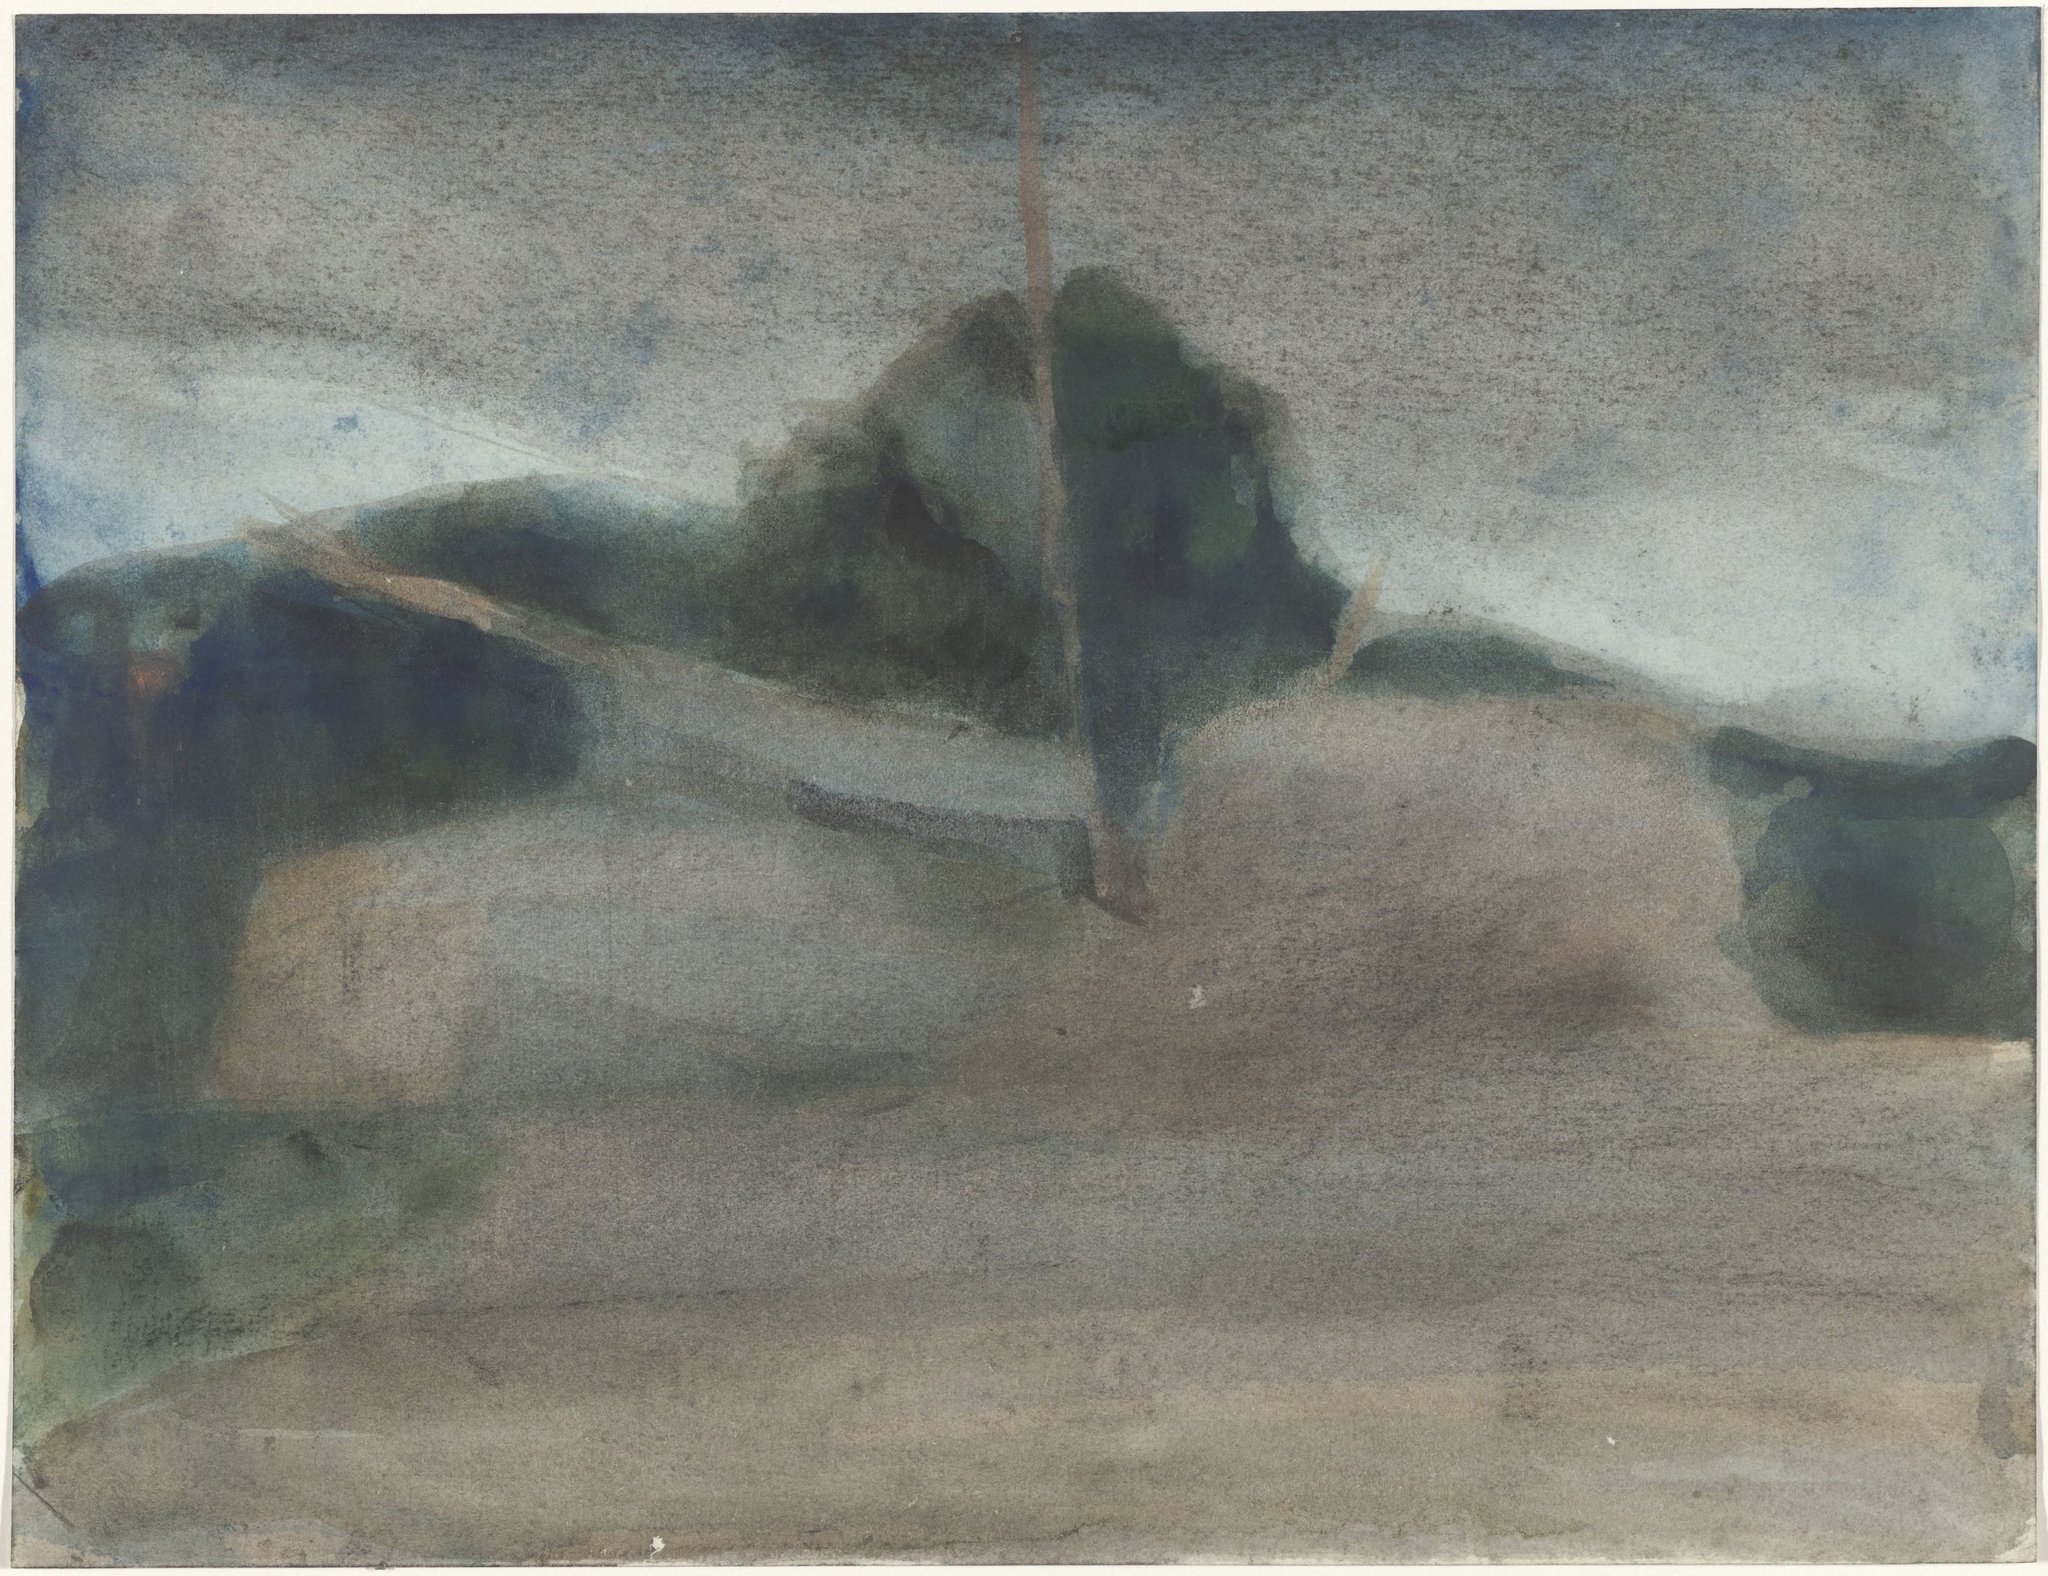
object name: watercolor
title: Landschap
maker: carel adolph lion cachet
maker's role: draughtsman, print maker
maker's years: 1864-1945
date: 1874-1945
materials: chalk, paper, watercolor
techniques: brush